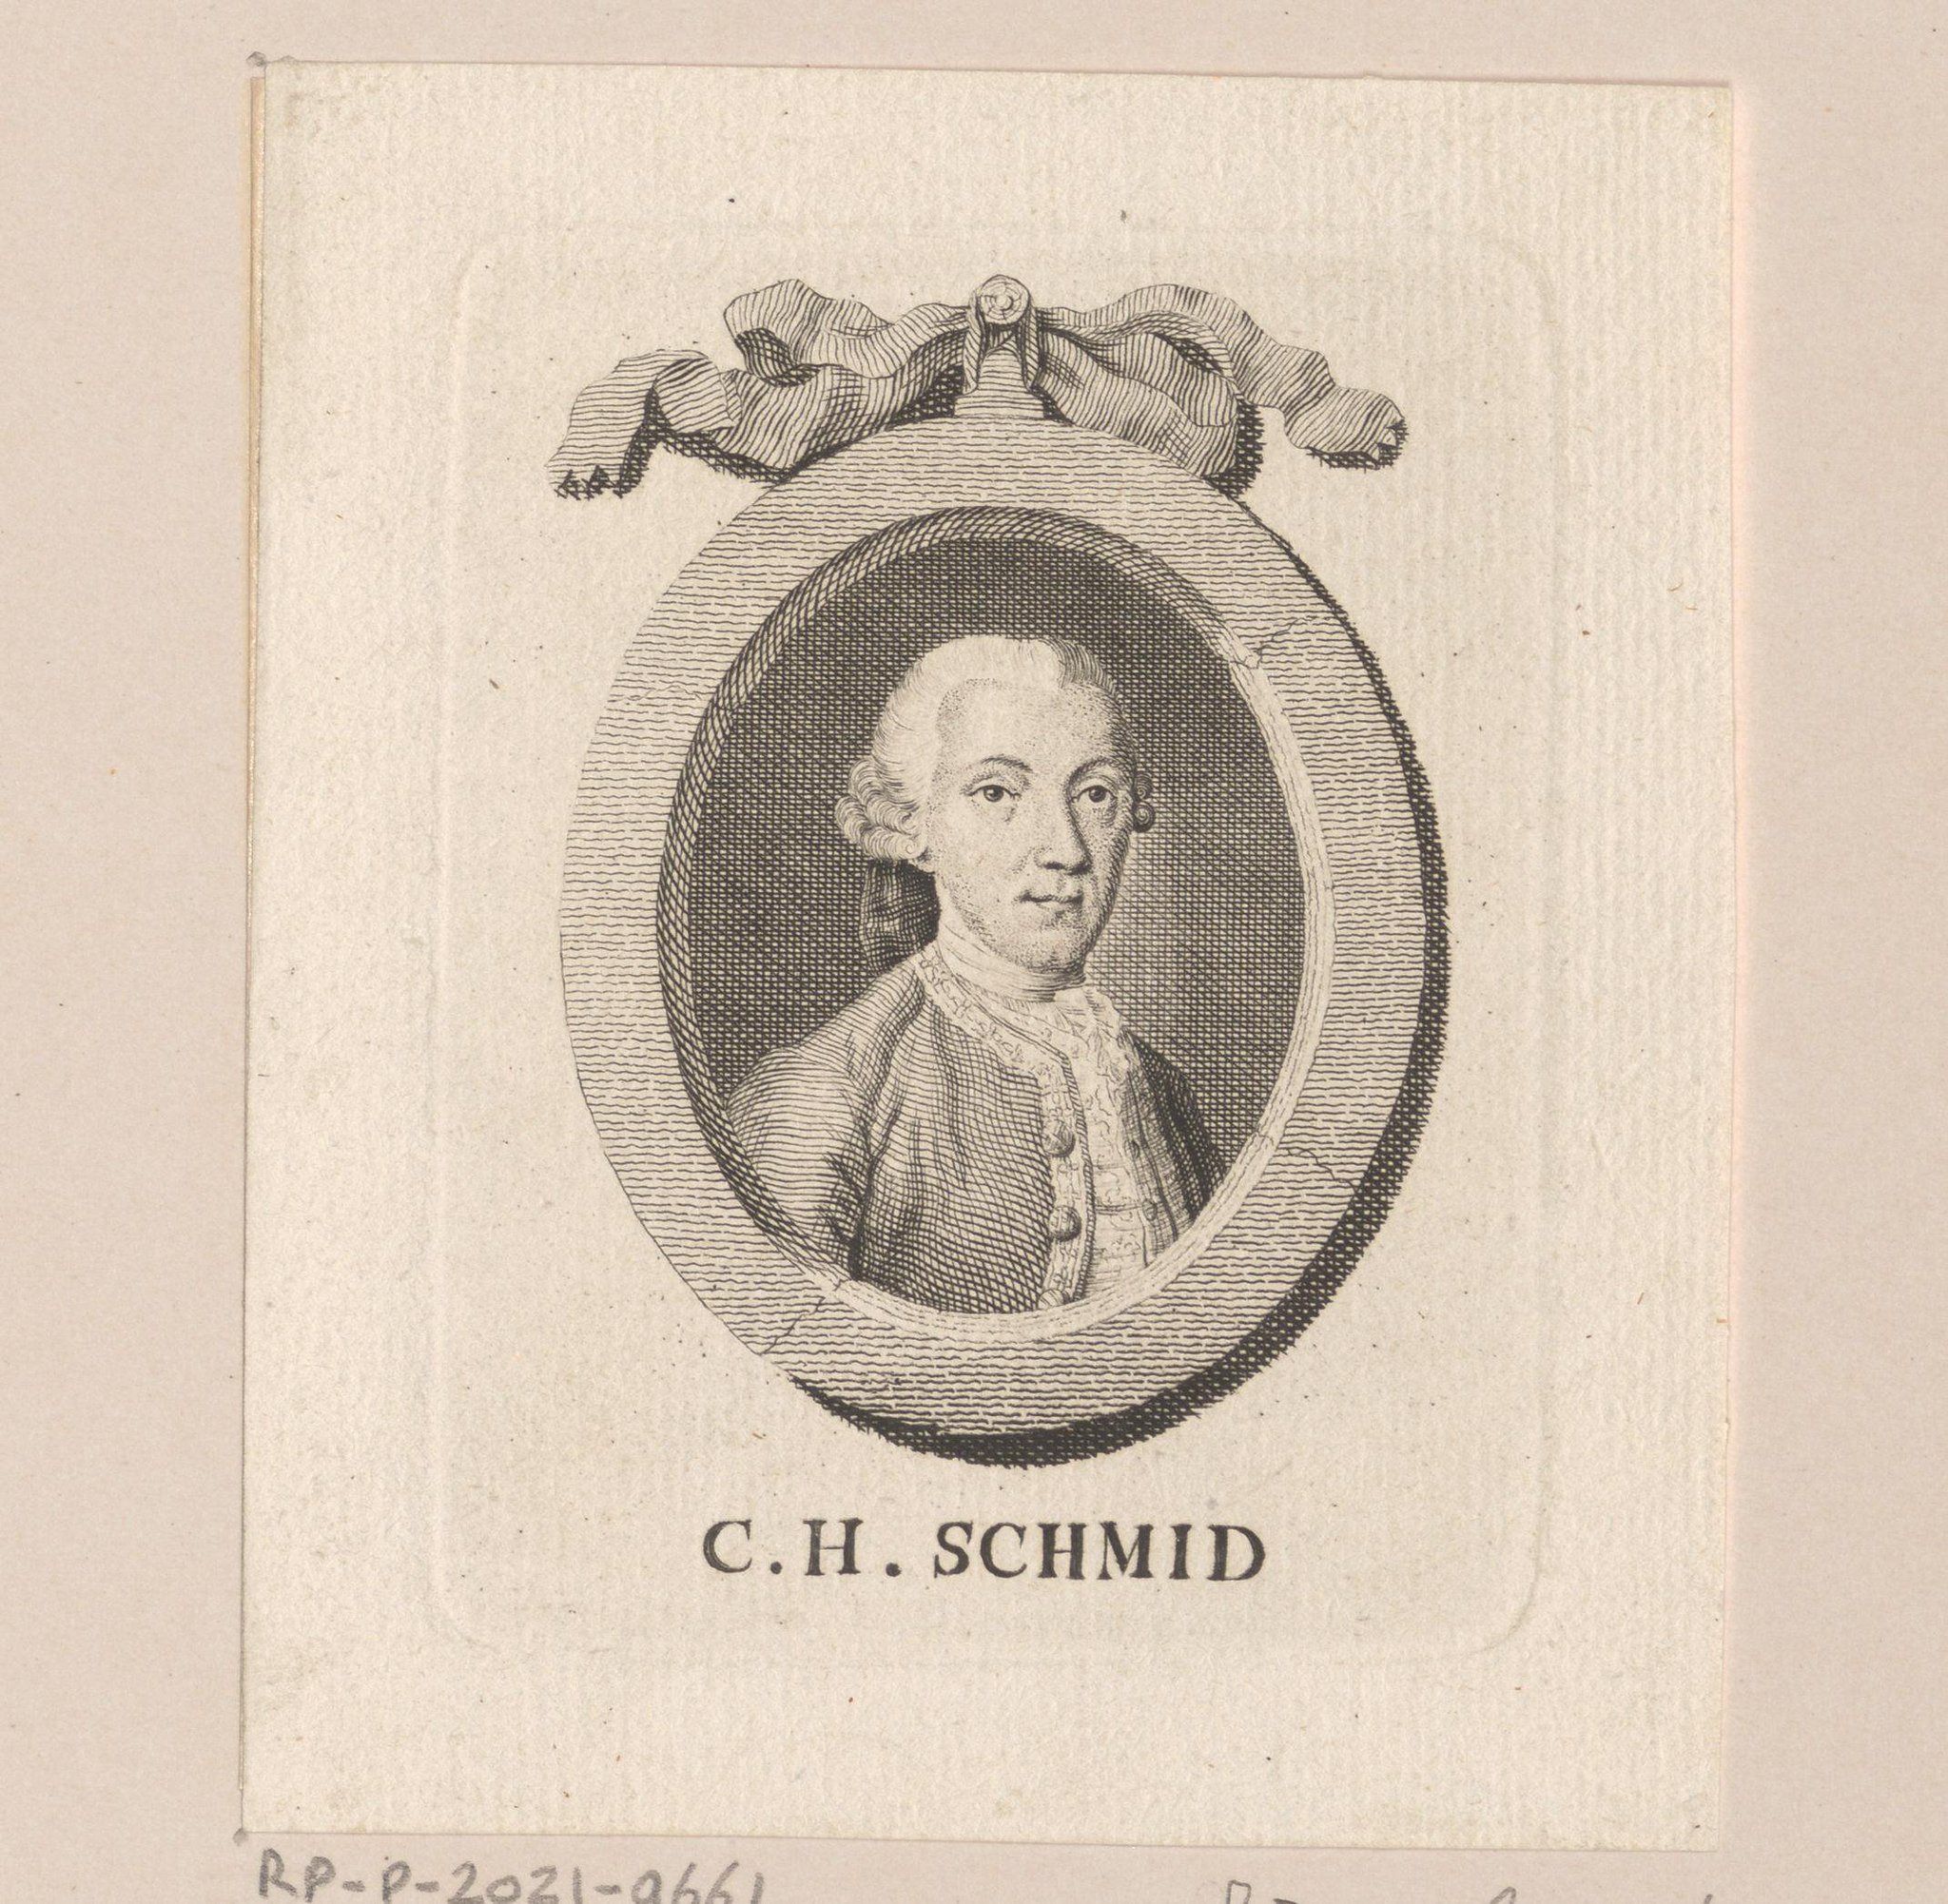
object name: print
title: Portret van Christian Heinrich Schmid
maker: Anonymous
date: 1762-1799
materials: paper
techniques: engraving, etching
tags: scholar, philosopher, historical persons